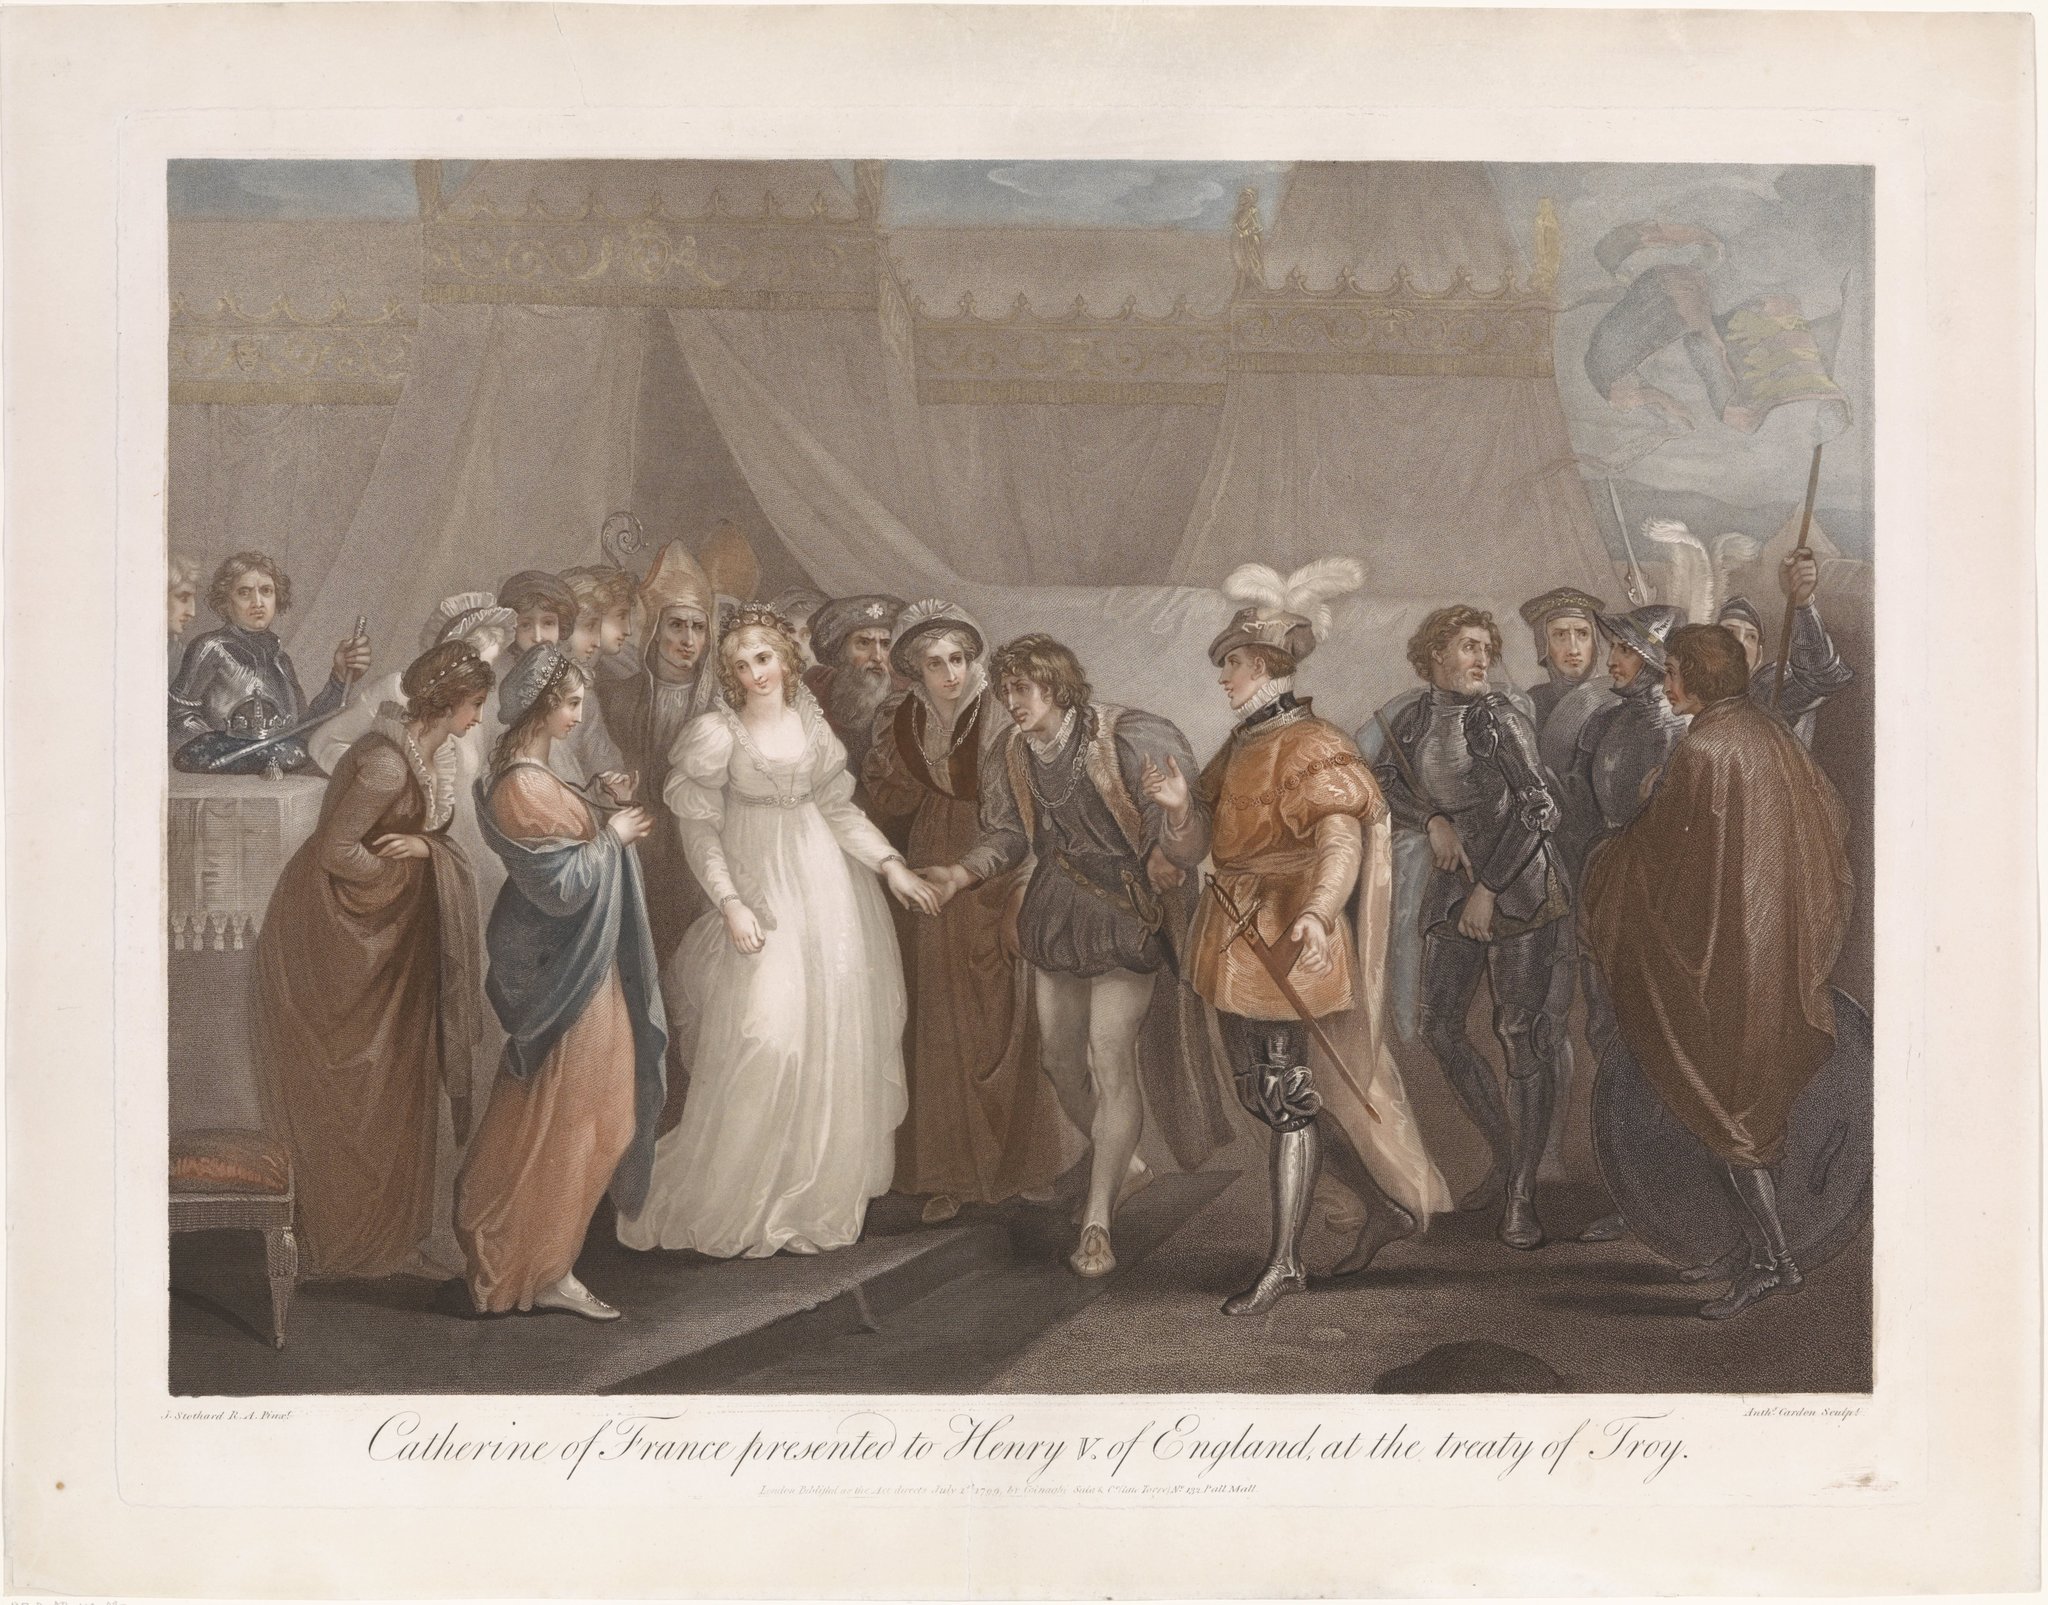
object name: print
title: Catherine van Valois en koning Hendrik V van Engeland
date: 1799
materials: paper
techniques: printing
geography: london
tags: (civil) marriage ceremonies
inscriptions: collector's mark: Lugt 2228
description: Catherine van Valois wordt aan haar toekomstige echtgenoot koning Hendrik V van Engeland geintroduceerd.